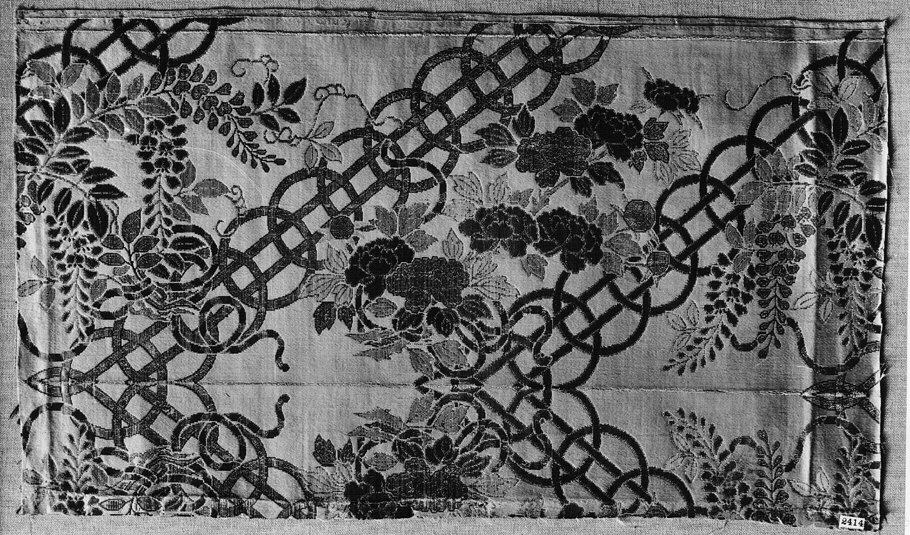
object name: piece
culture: japanese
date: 1801-1900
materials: silk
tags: flowers